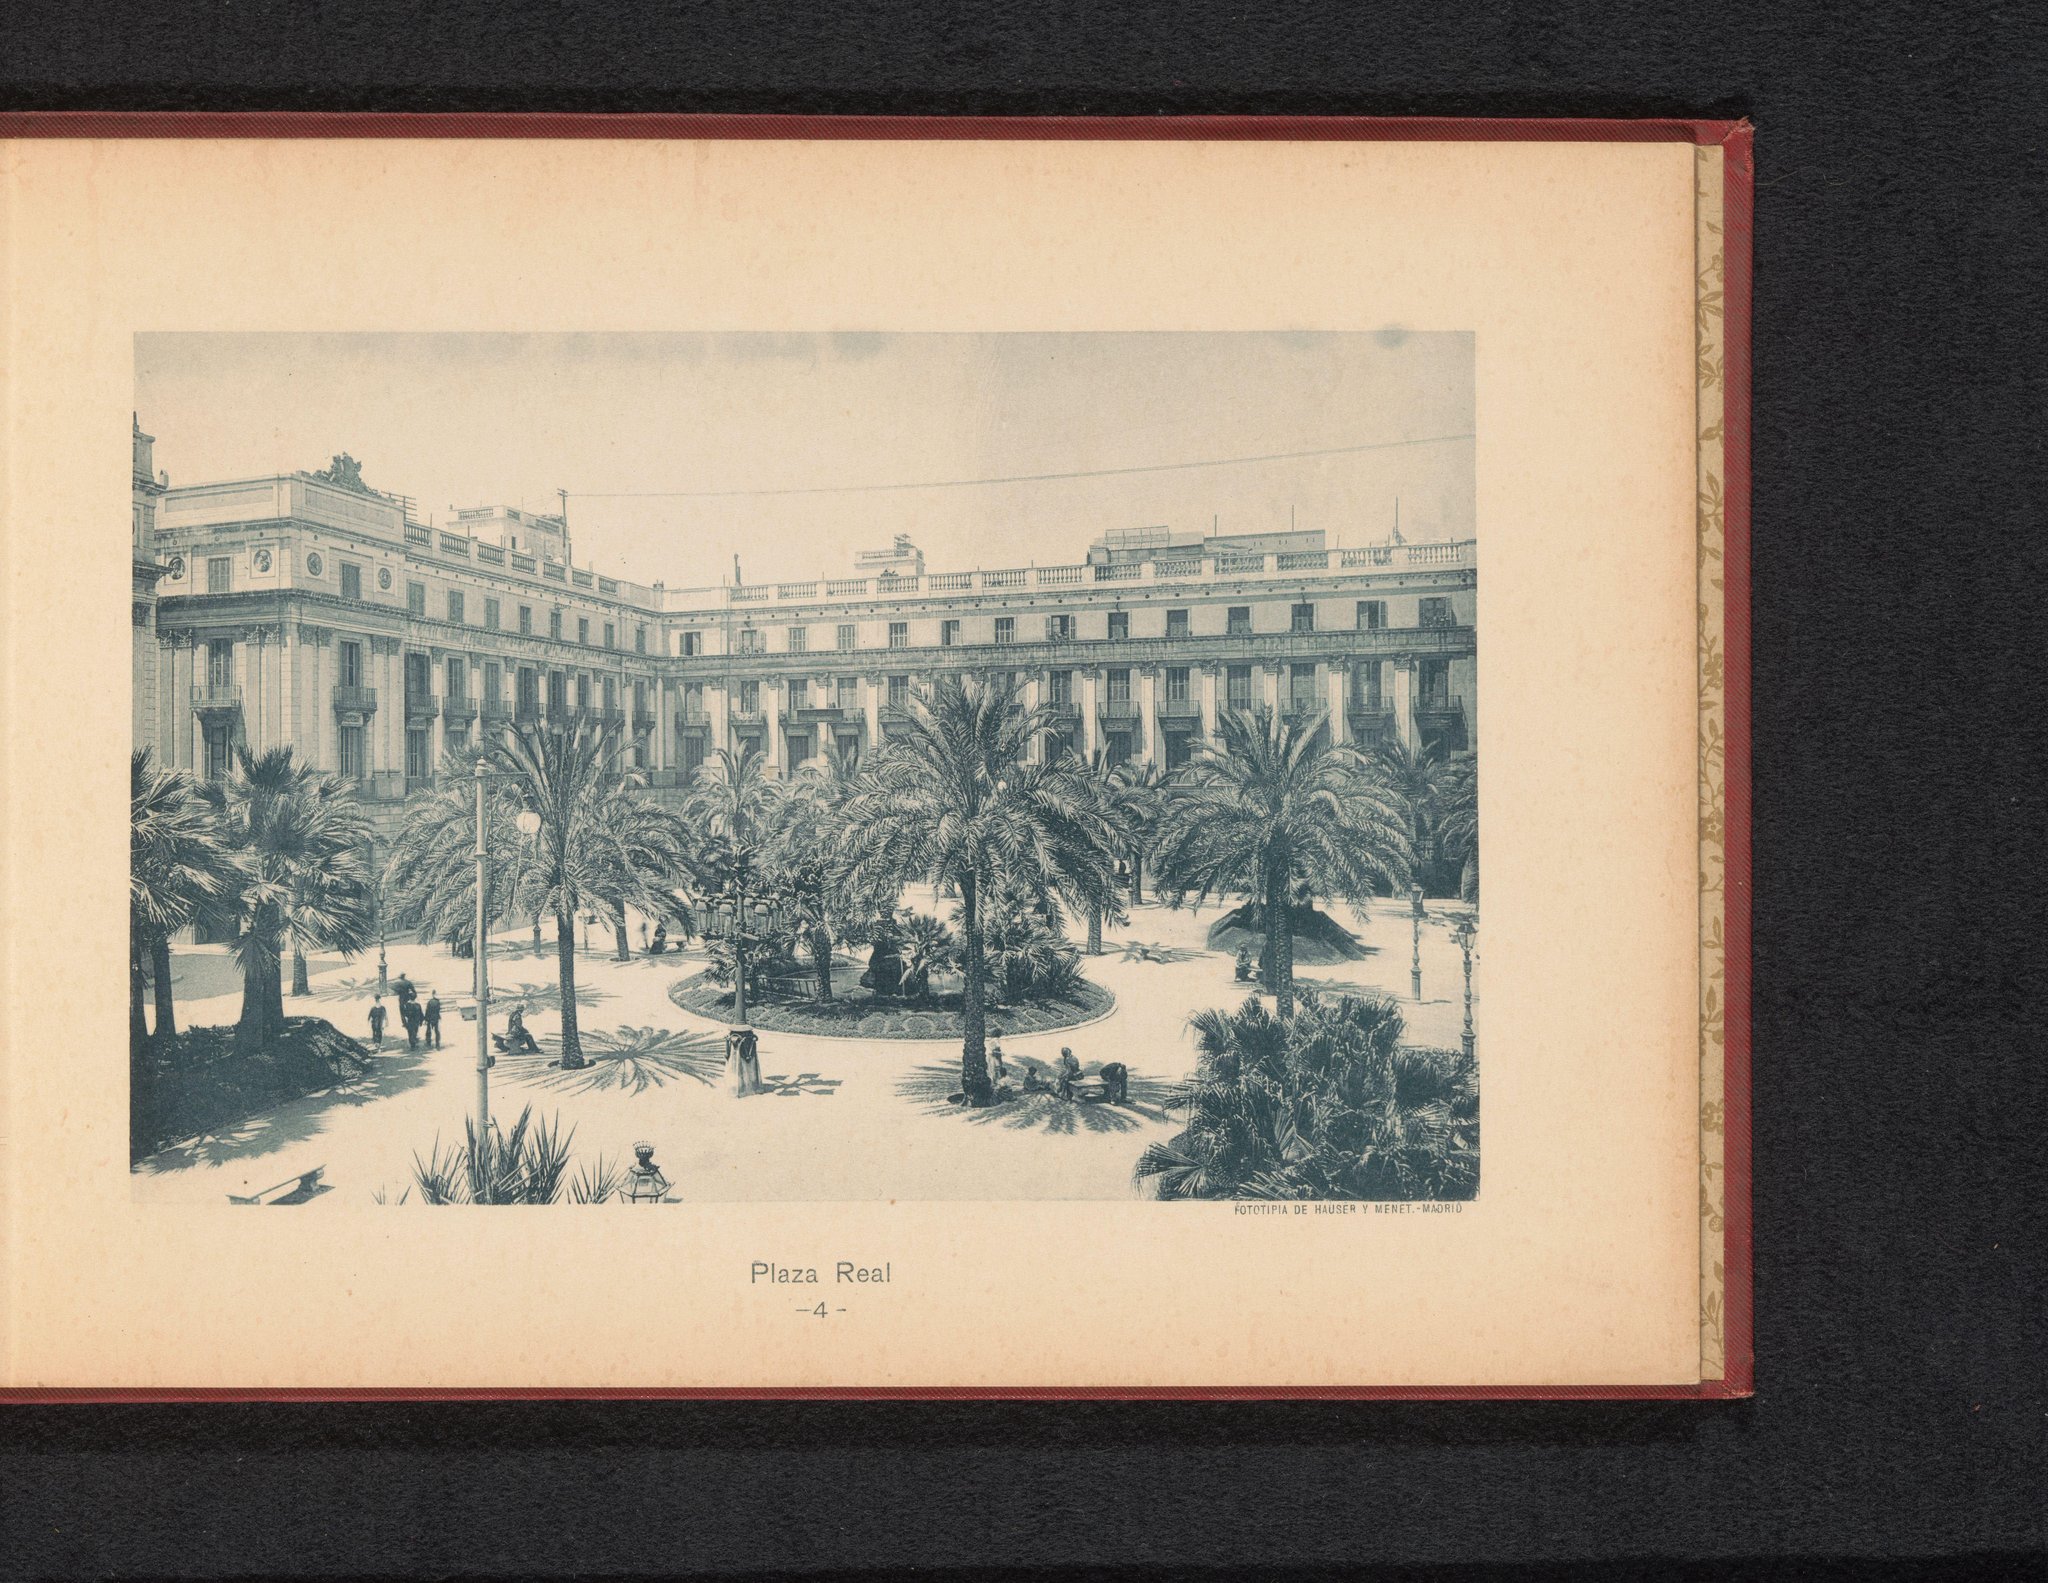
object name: page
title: Plaza Real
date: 1880-1890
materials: paper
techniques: photograph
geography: plaça reial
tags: square, place, circus, etc.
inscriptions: number: ‘-4-’